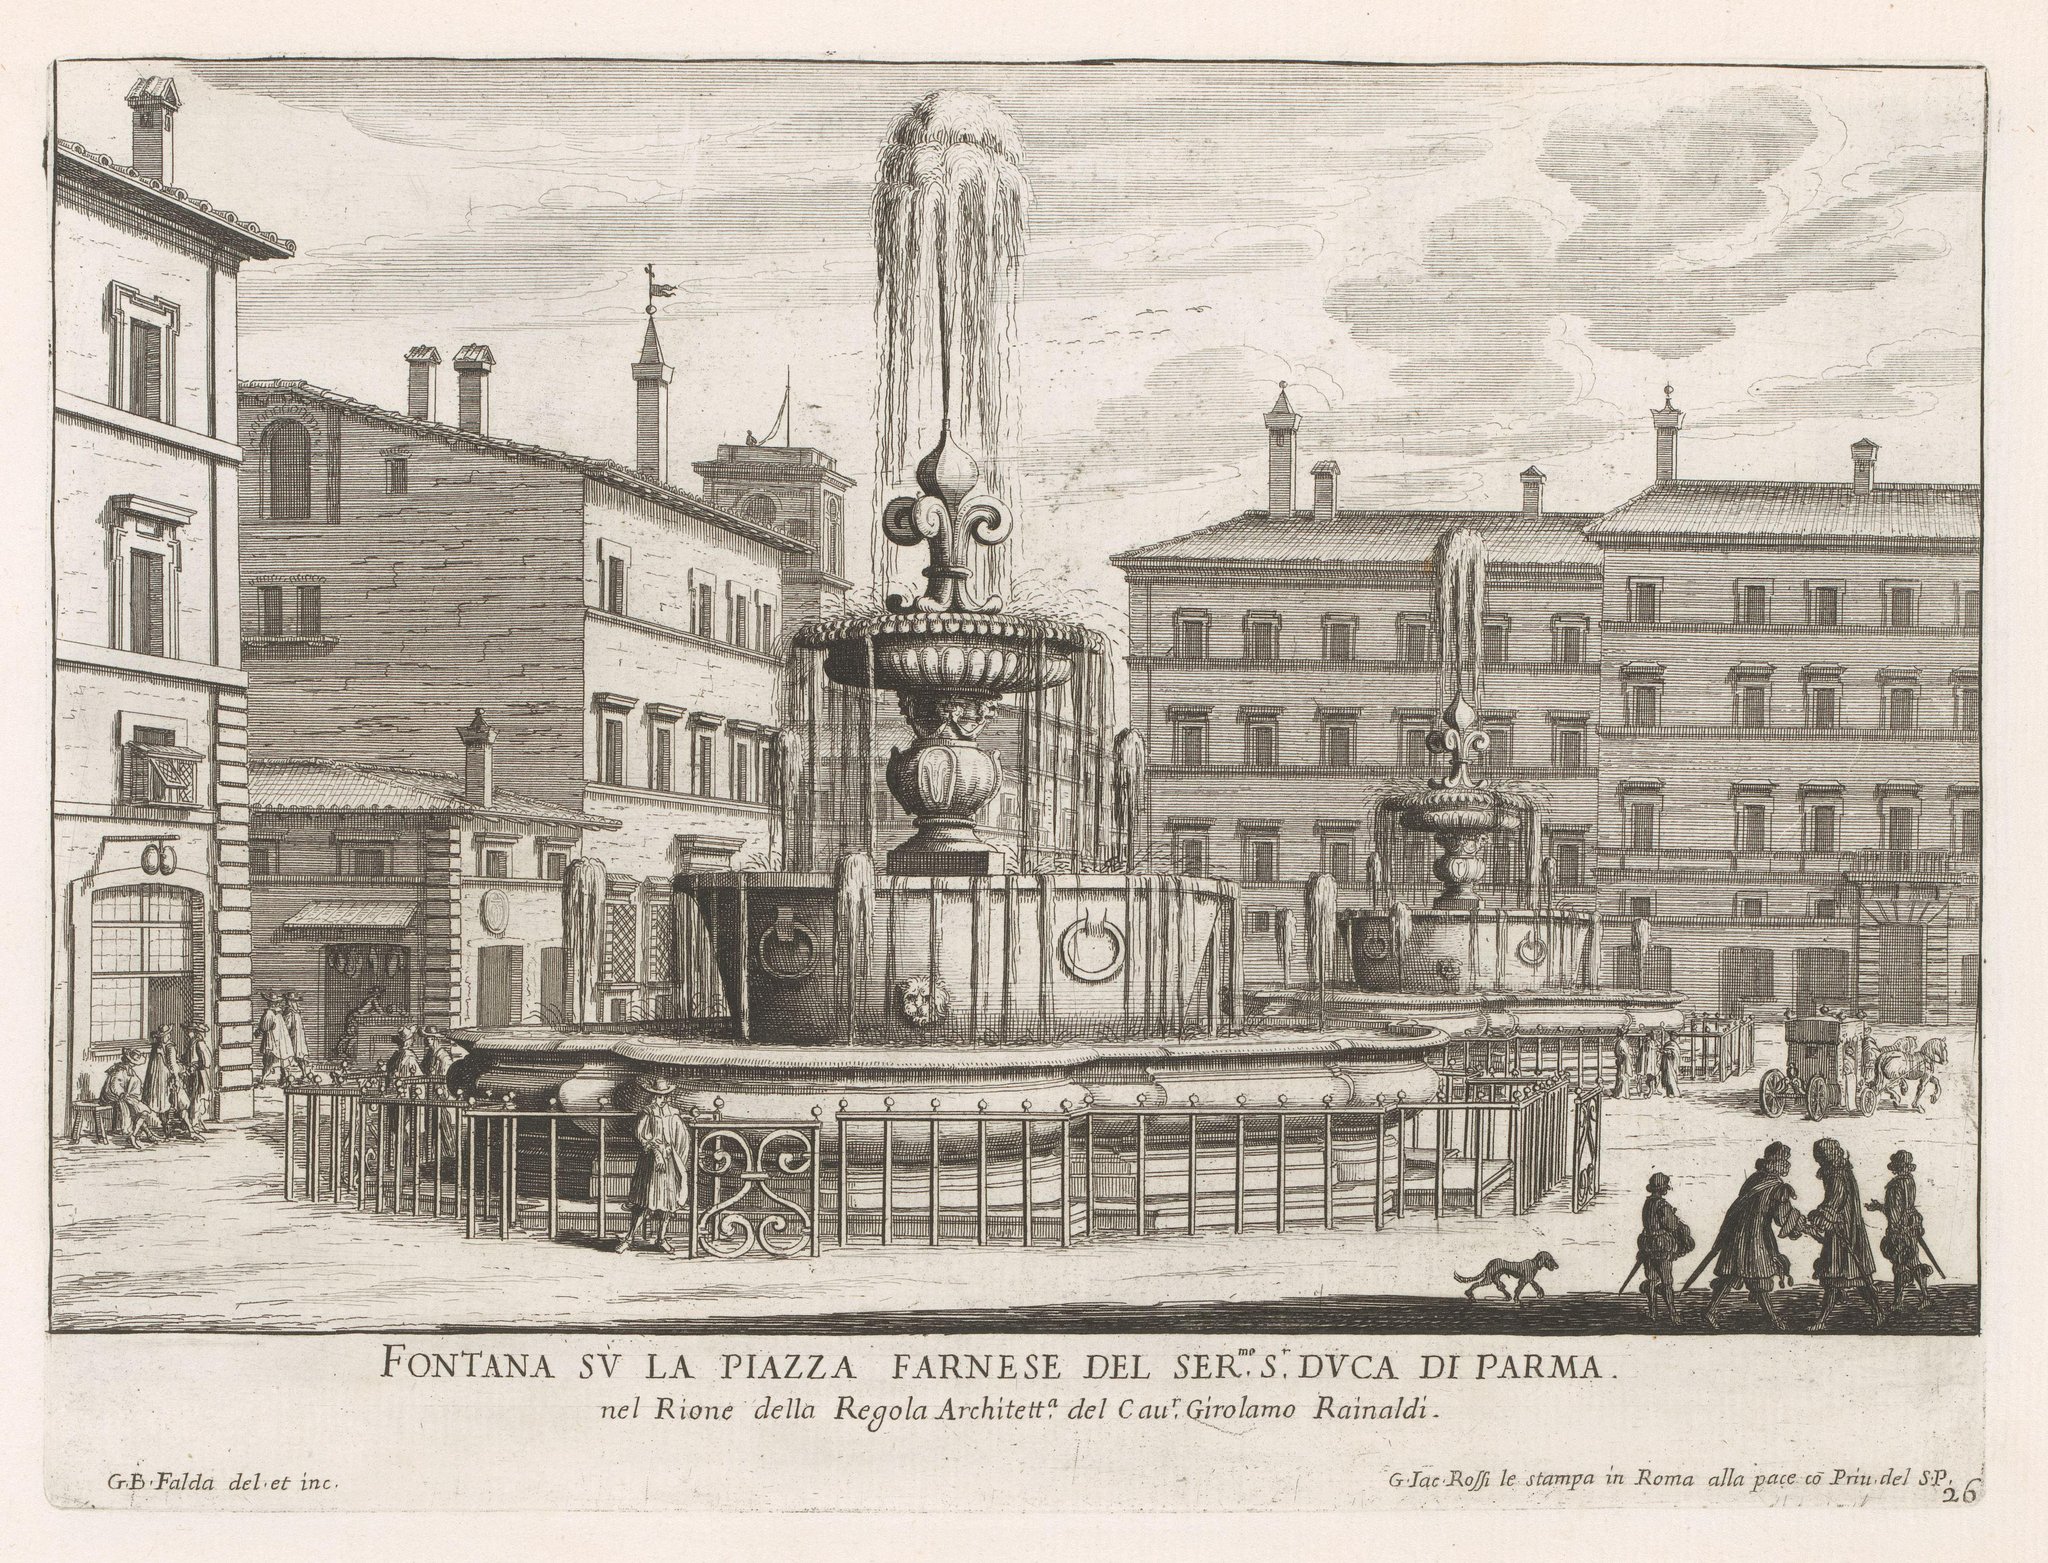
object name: print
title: Fonteinen van Rome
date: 1653-1691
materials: paper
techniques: etching, intaglio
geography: italy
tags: ornamental fountain, rome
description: De twee identieke Fontane di Piazza Farnese. Genummerd rechtsonder: 26. De prent maakt deel uit van een album.